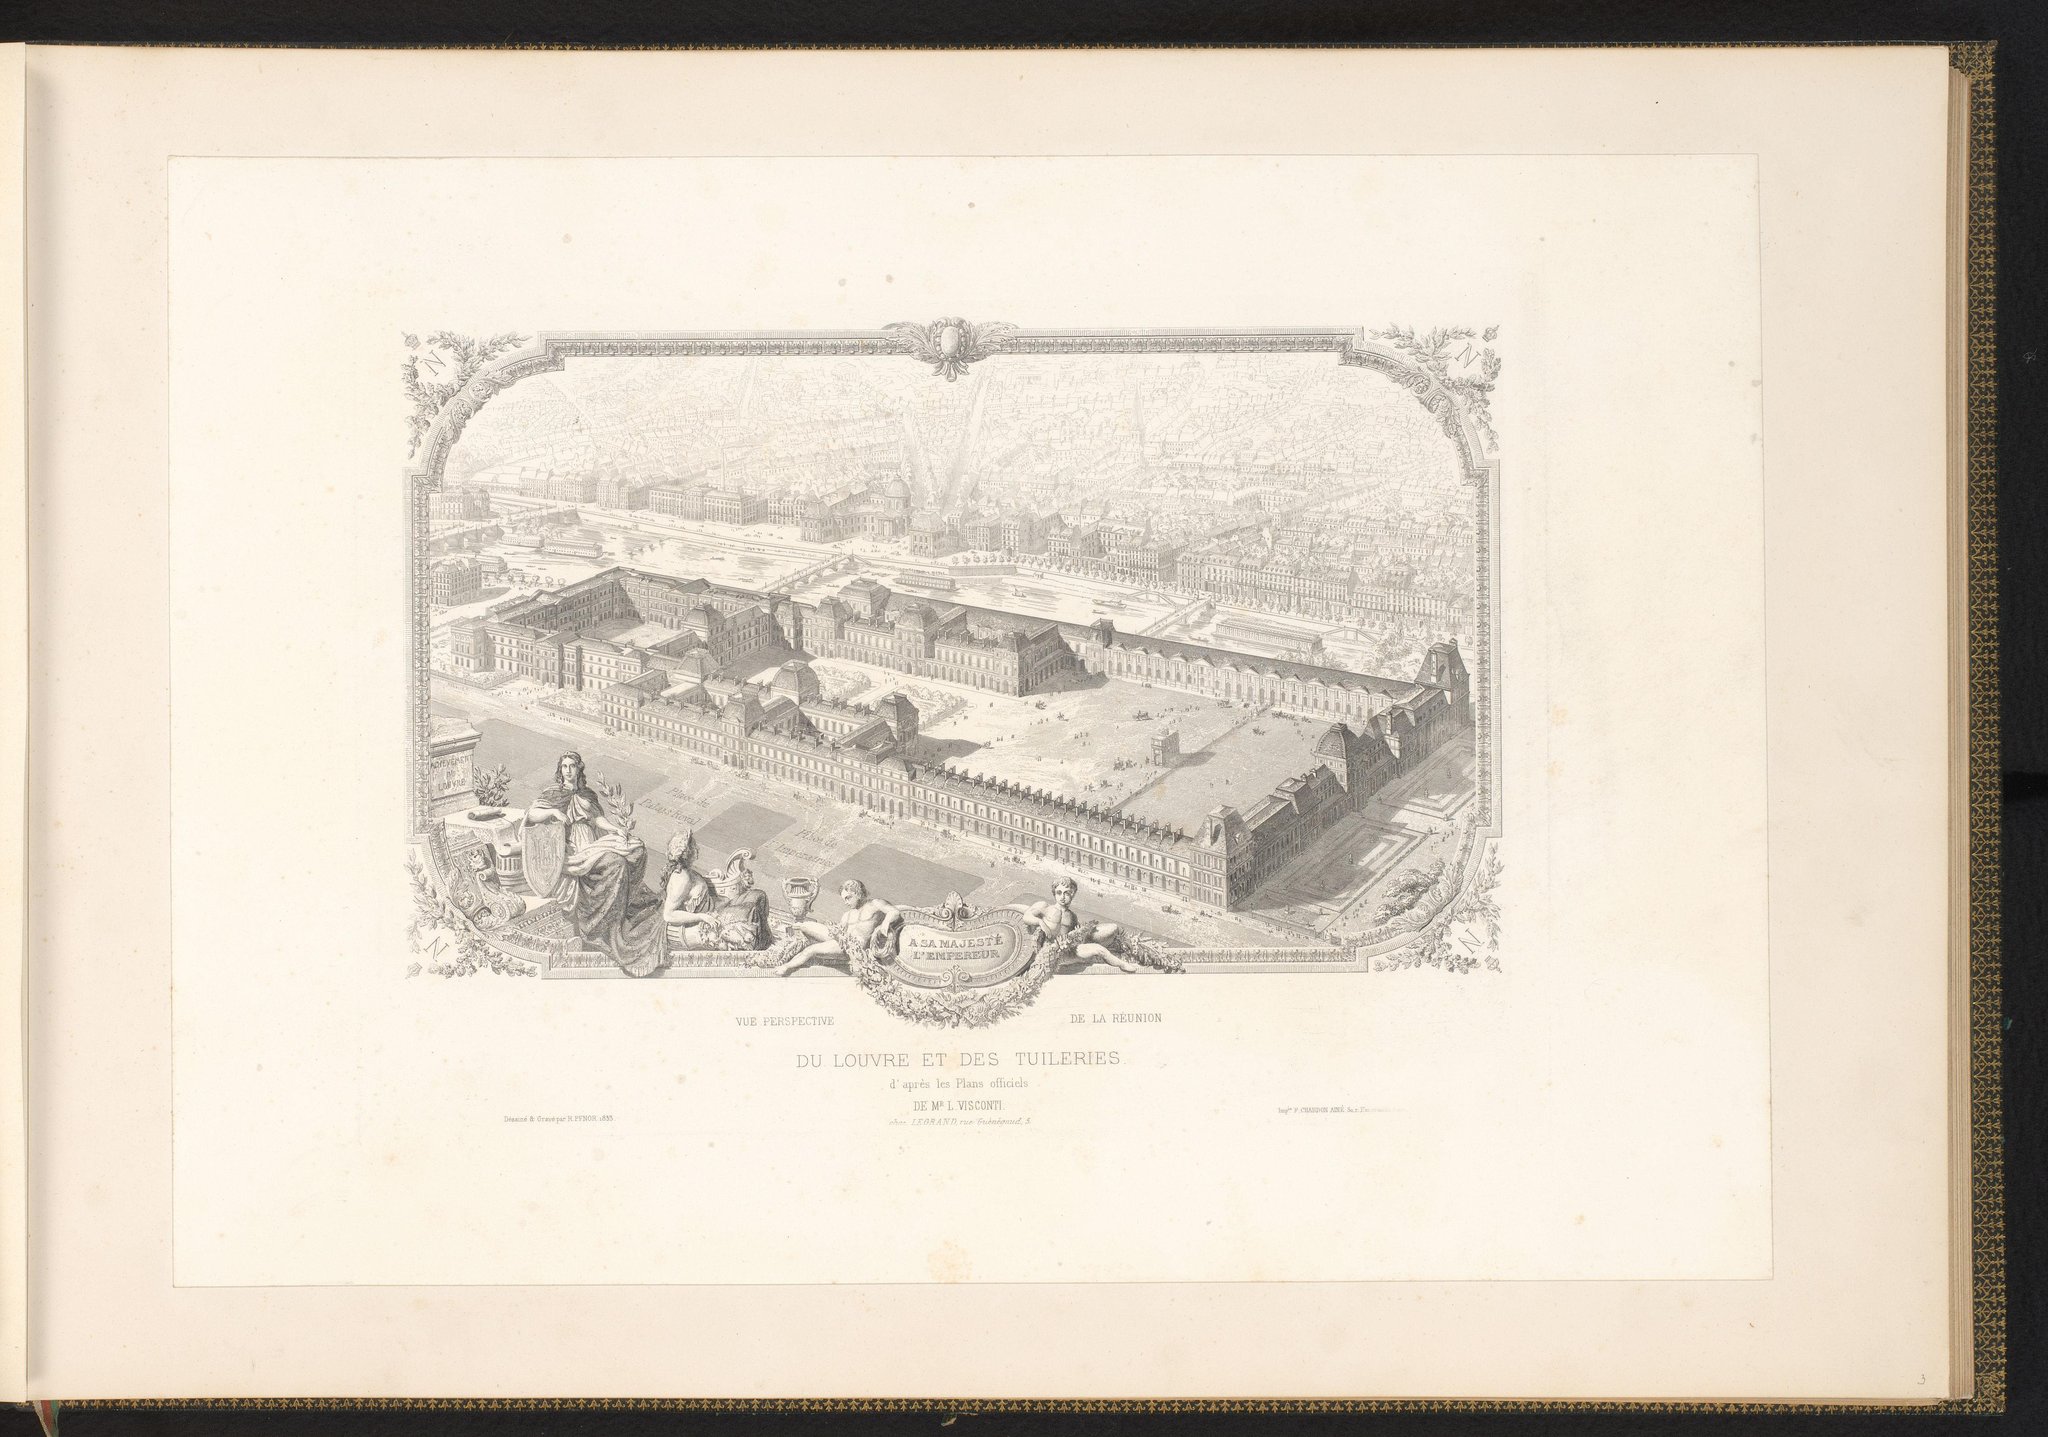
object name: album leaf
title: Vue perspective de la réunion du Louvre et des Tuileries d'apres les Plan officiels de Mr. L. Visconti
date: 1853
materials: paper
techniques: engraving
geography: paris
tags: permanent exhibition, museum, paris, tuileries palace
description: Onderdeel van Réunion des Tuileries au Louvre 1852-1857, album 1.